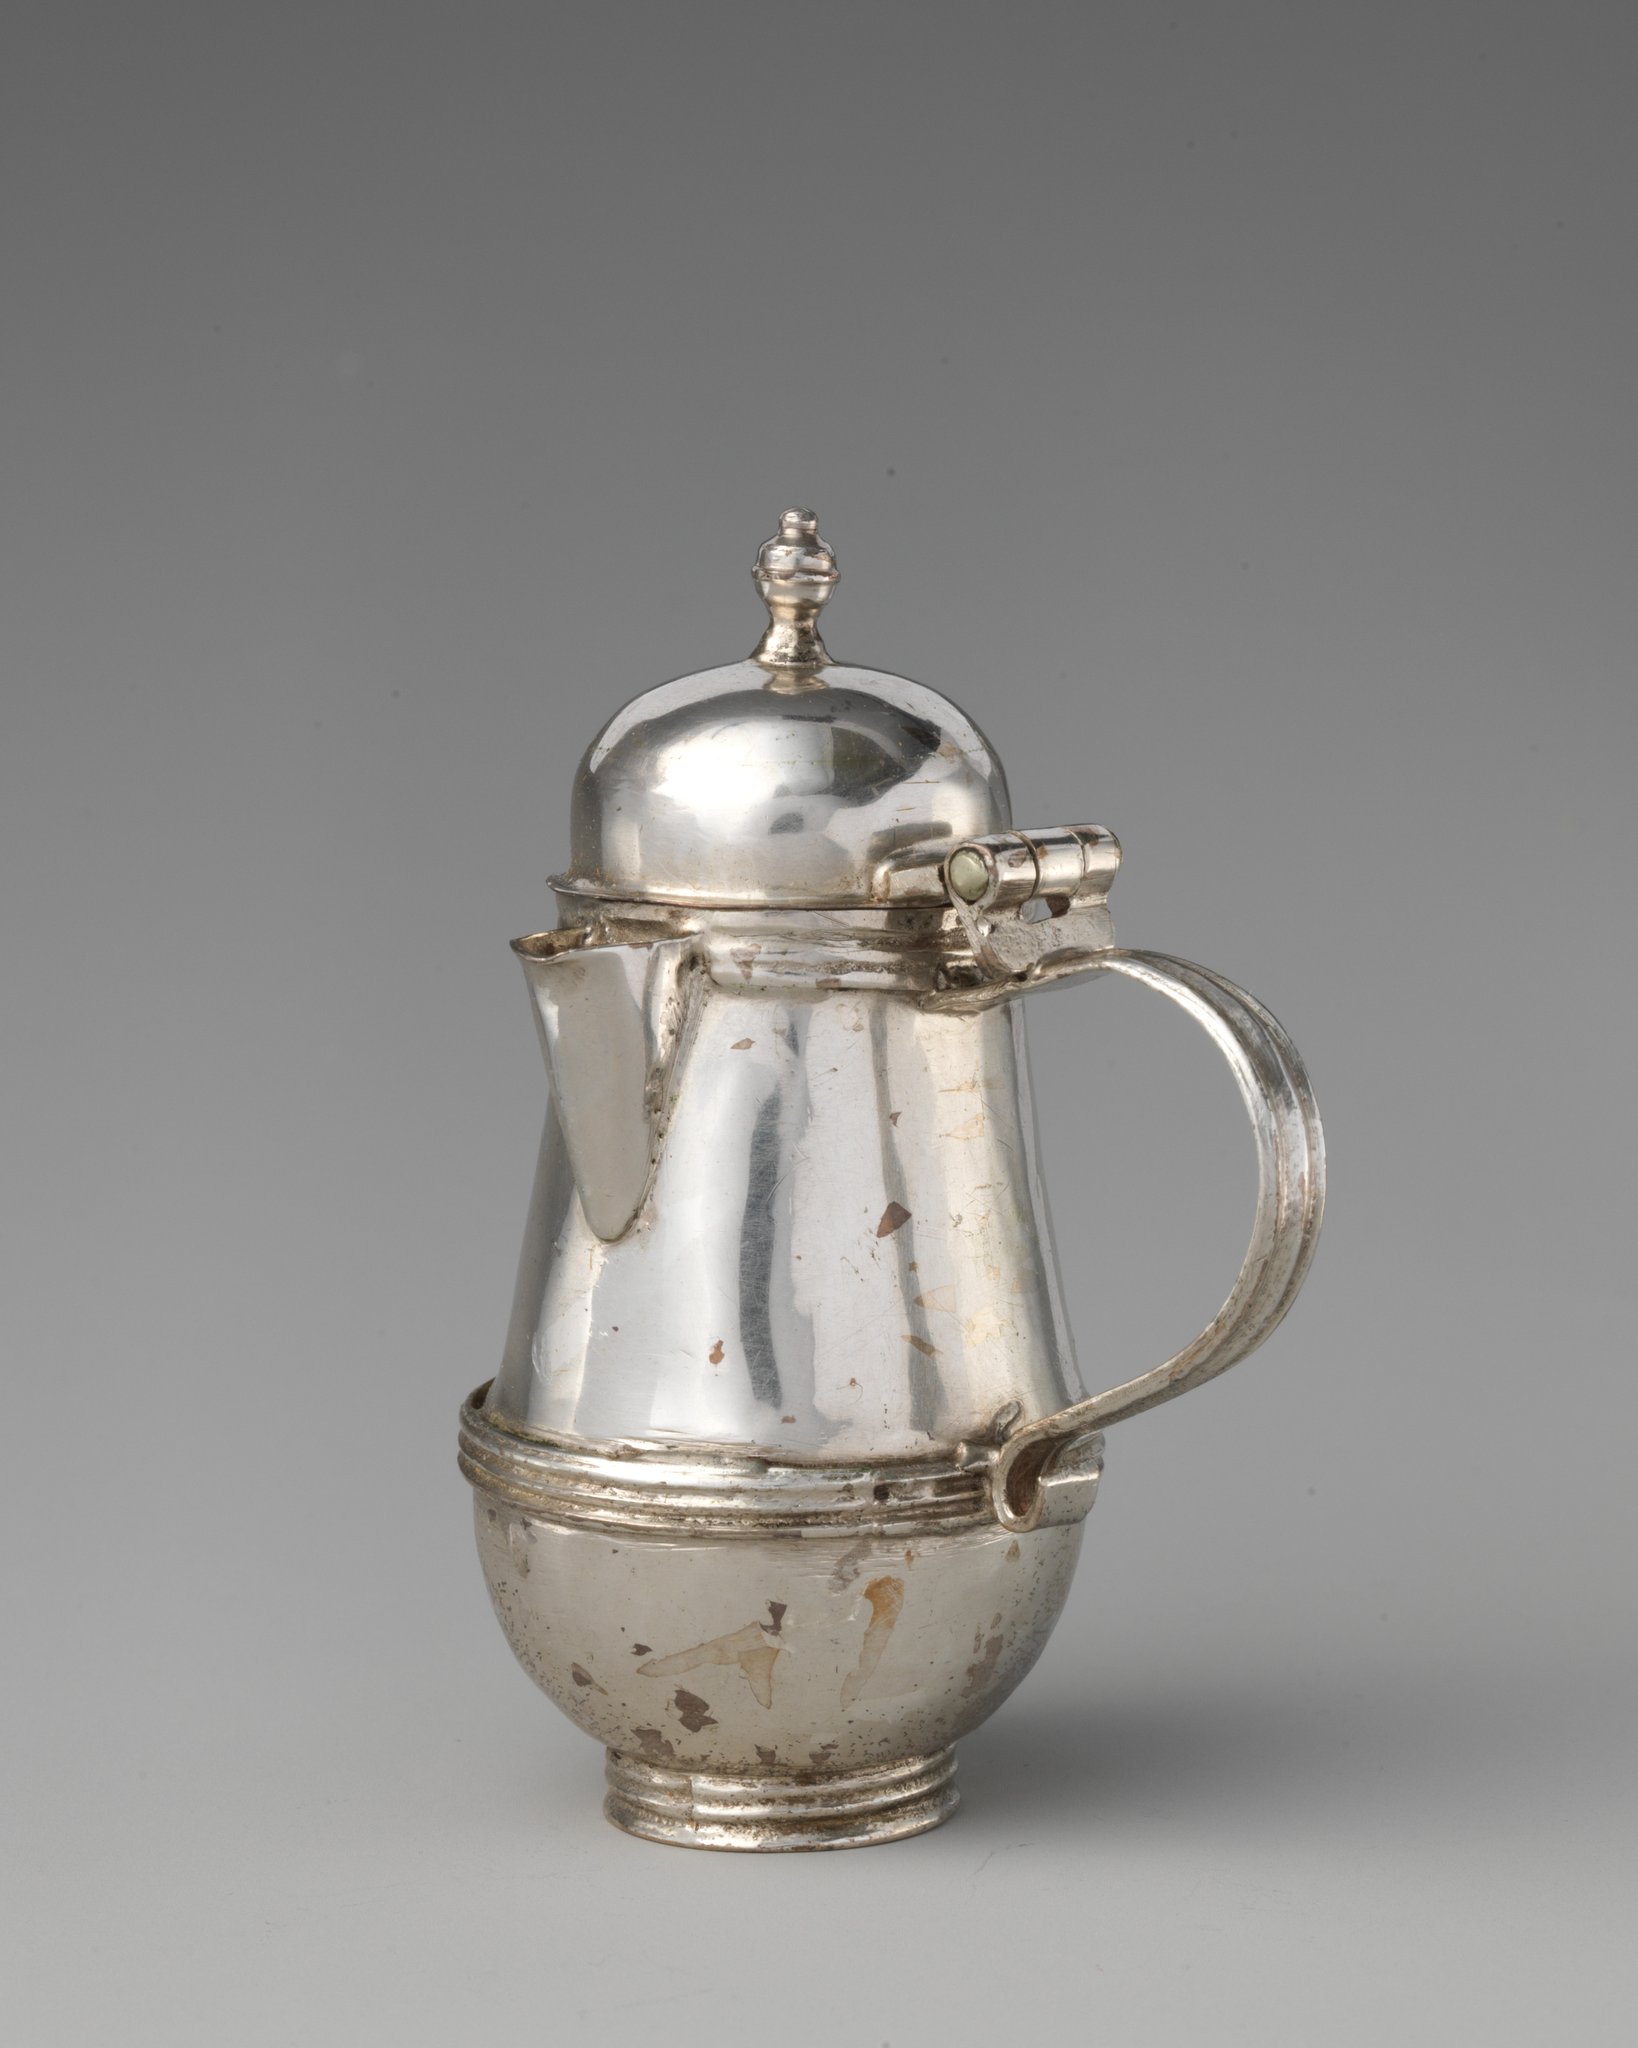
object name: coffeepot with cover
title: Miniature coffeepot with hinged cover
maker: george manjoy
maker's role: maker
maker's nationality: british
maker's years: 1685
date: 1701-1800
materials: silver